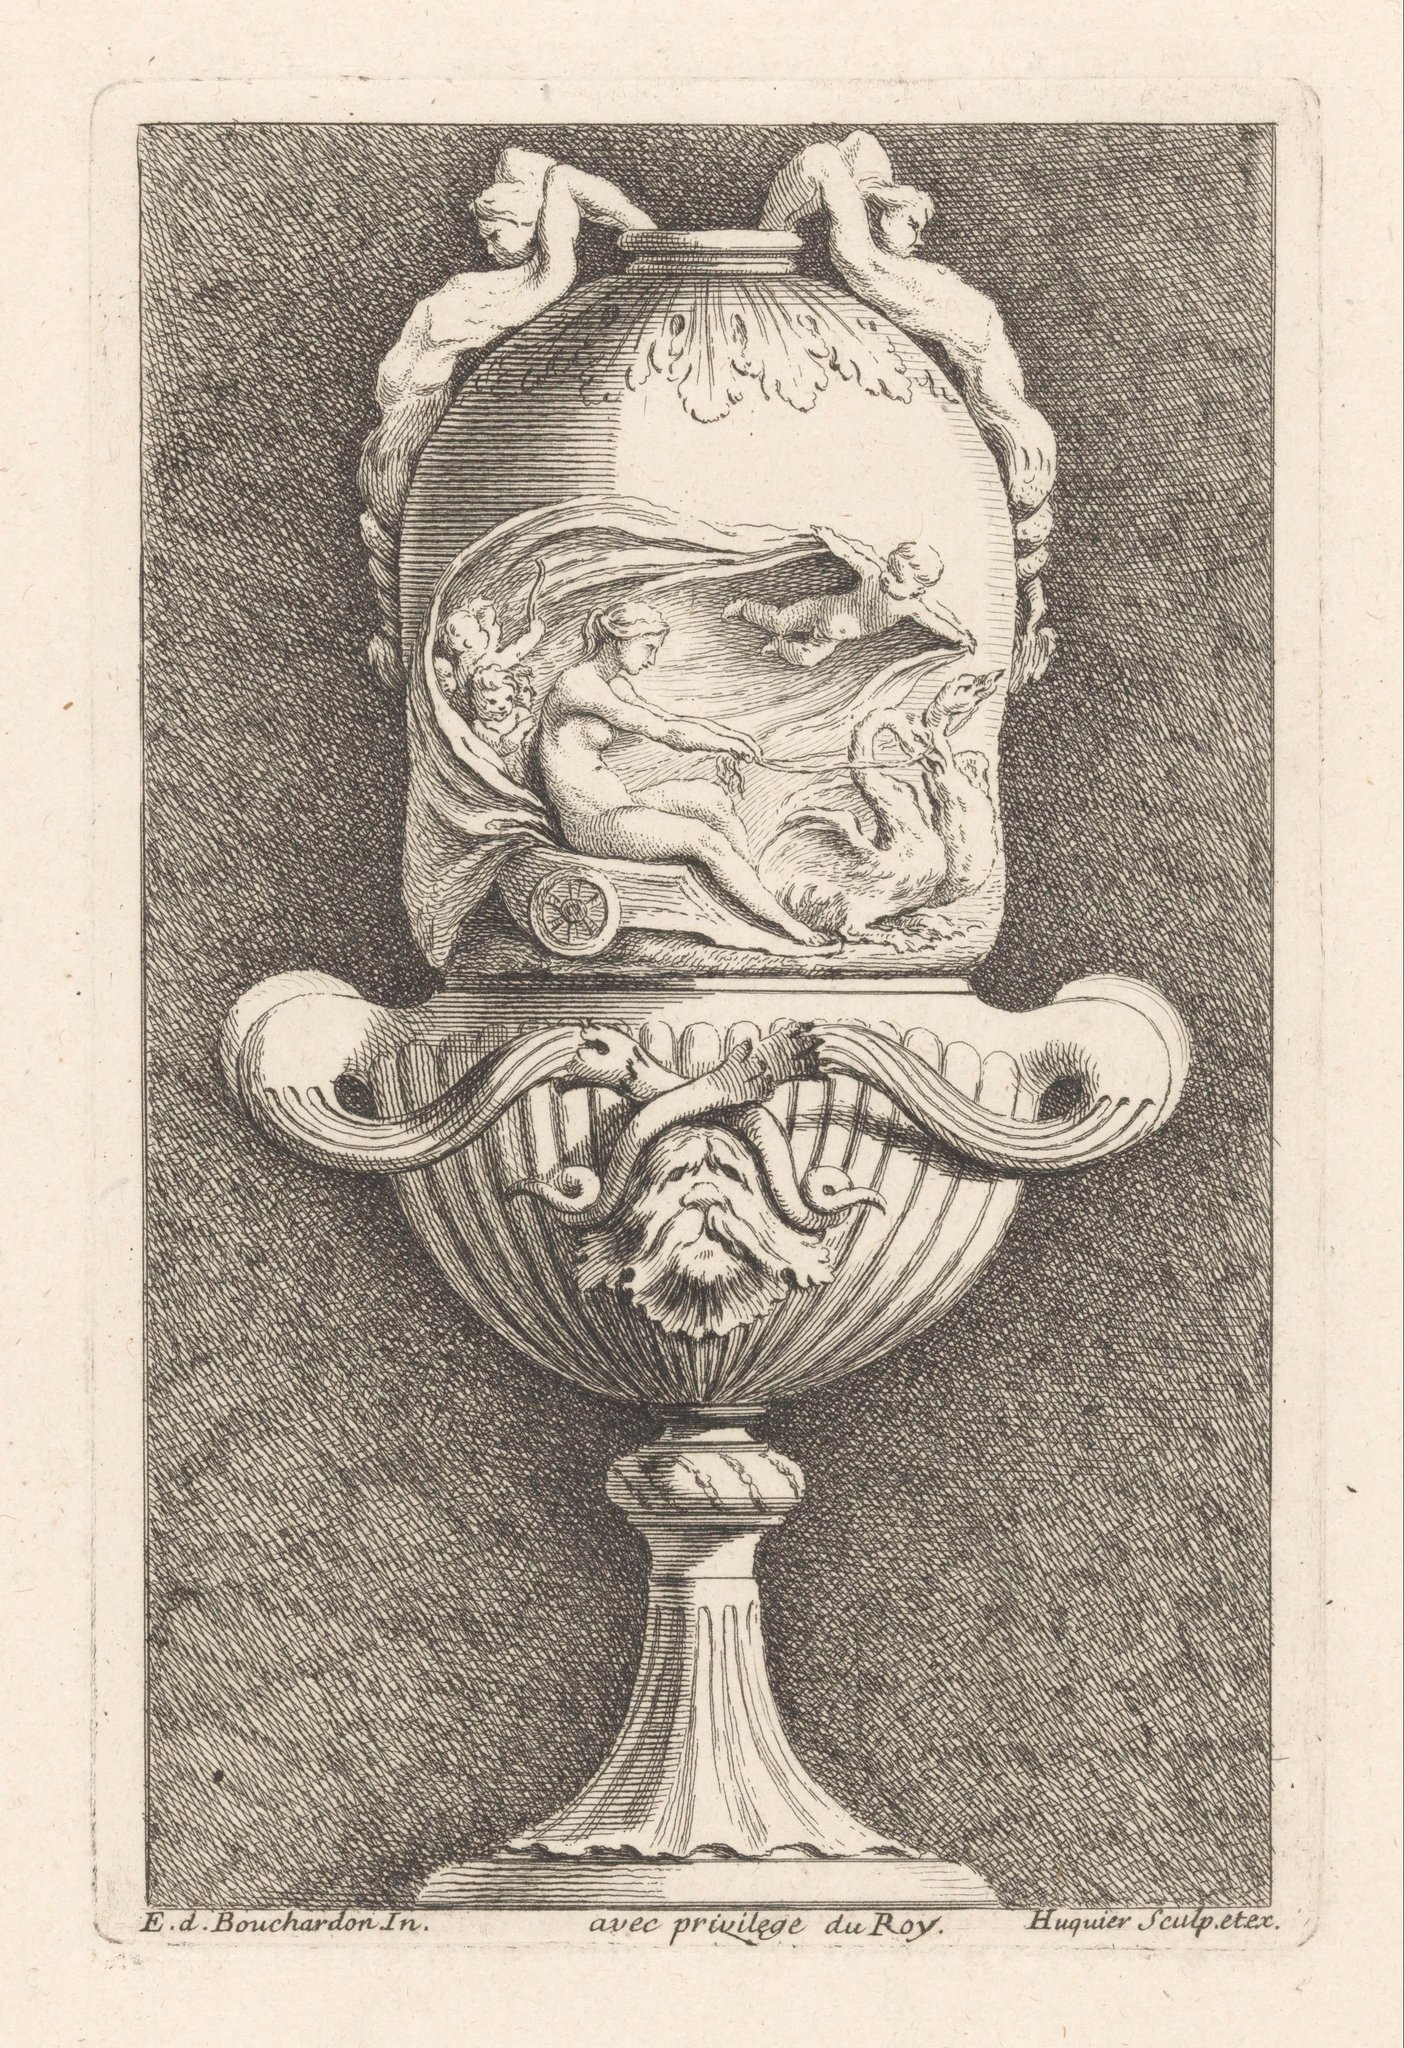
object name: ornament print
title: Vaas met Venus in een kar getrokken door zwanen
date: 1729-1737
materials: paper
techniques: etching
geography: paris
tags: water-birds: swan, vase ~ ornament, mask, mascaron ~ ornament, (story of) venus (aphrodite), cupids: 'amores', 'amoretti', 'putti'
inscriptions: collector's mark: Lugt 2228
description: Een vaas met Venus en putti in een kar getrokken door twee zwanen. Daaronder een masker. Aan de bovenzijde twee halffiguren.